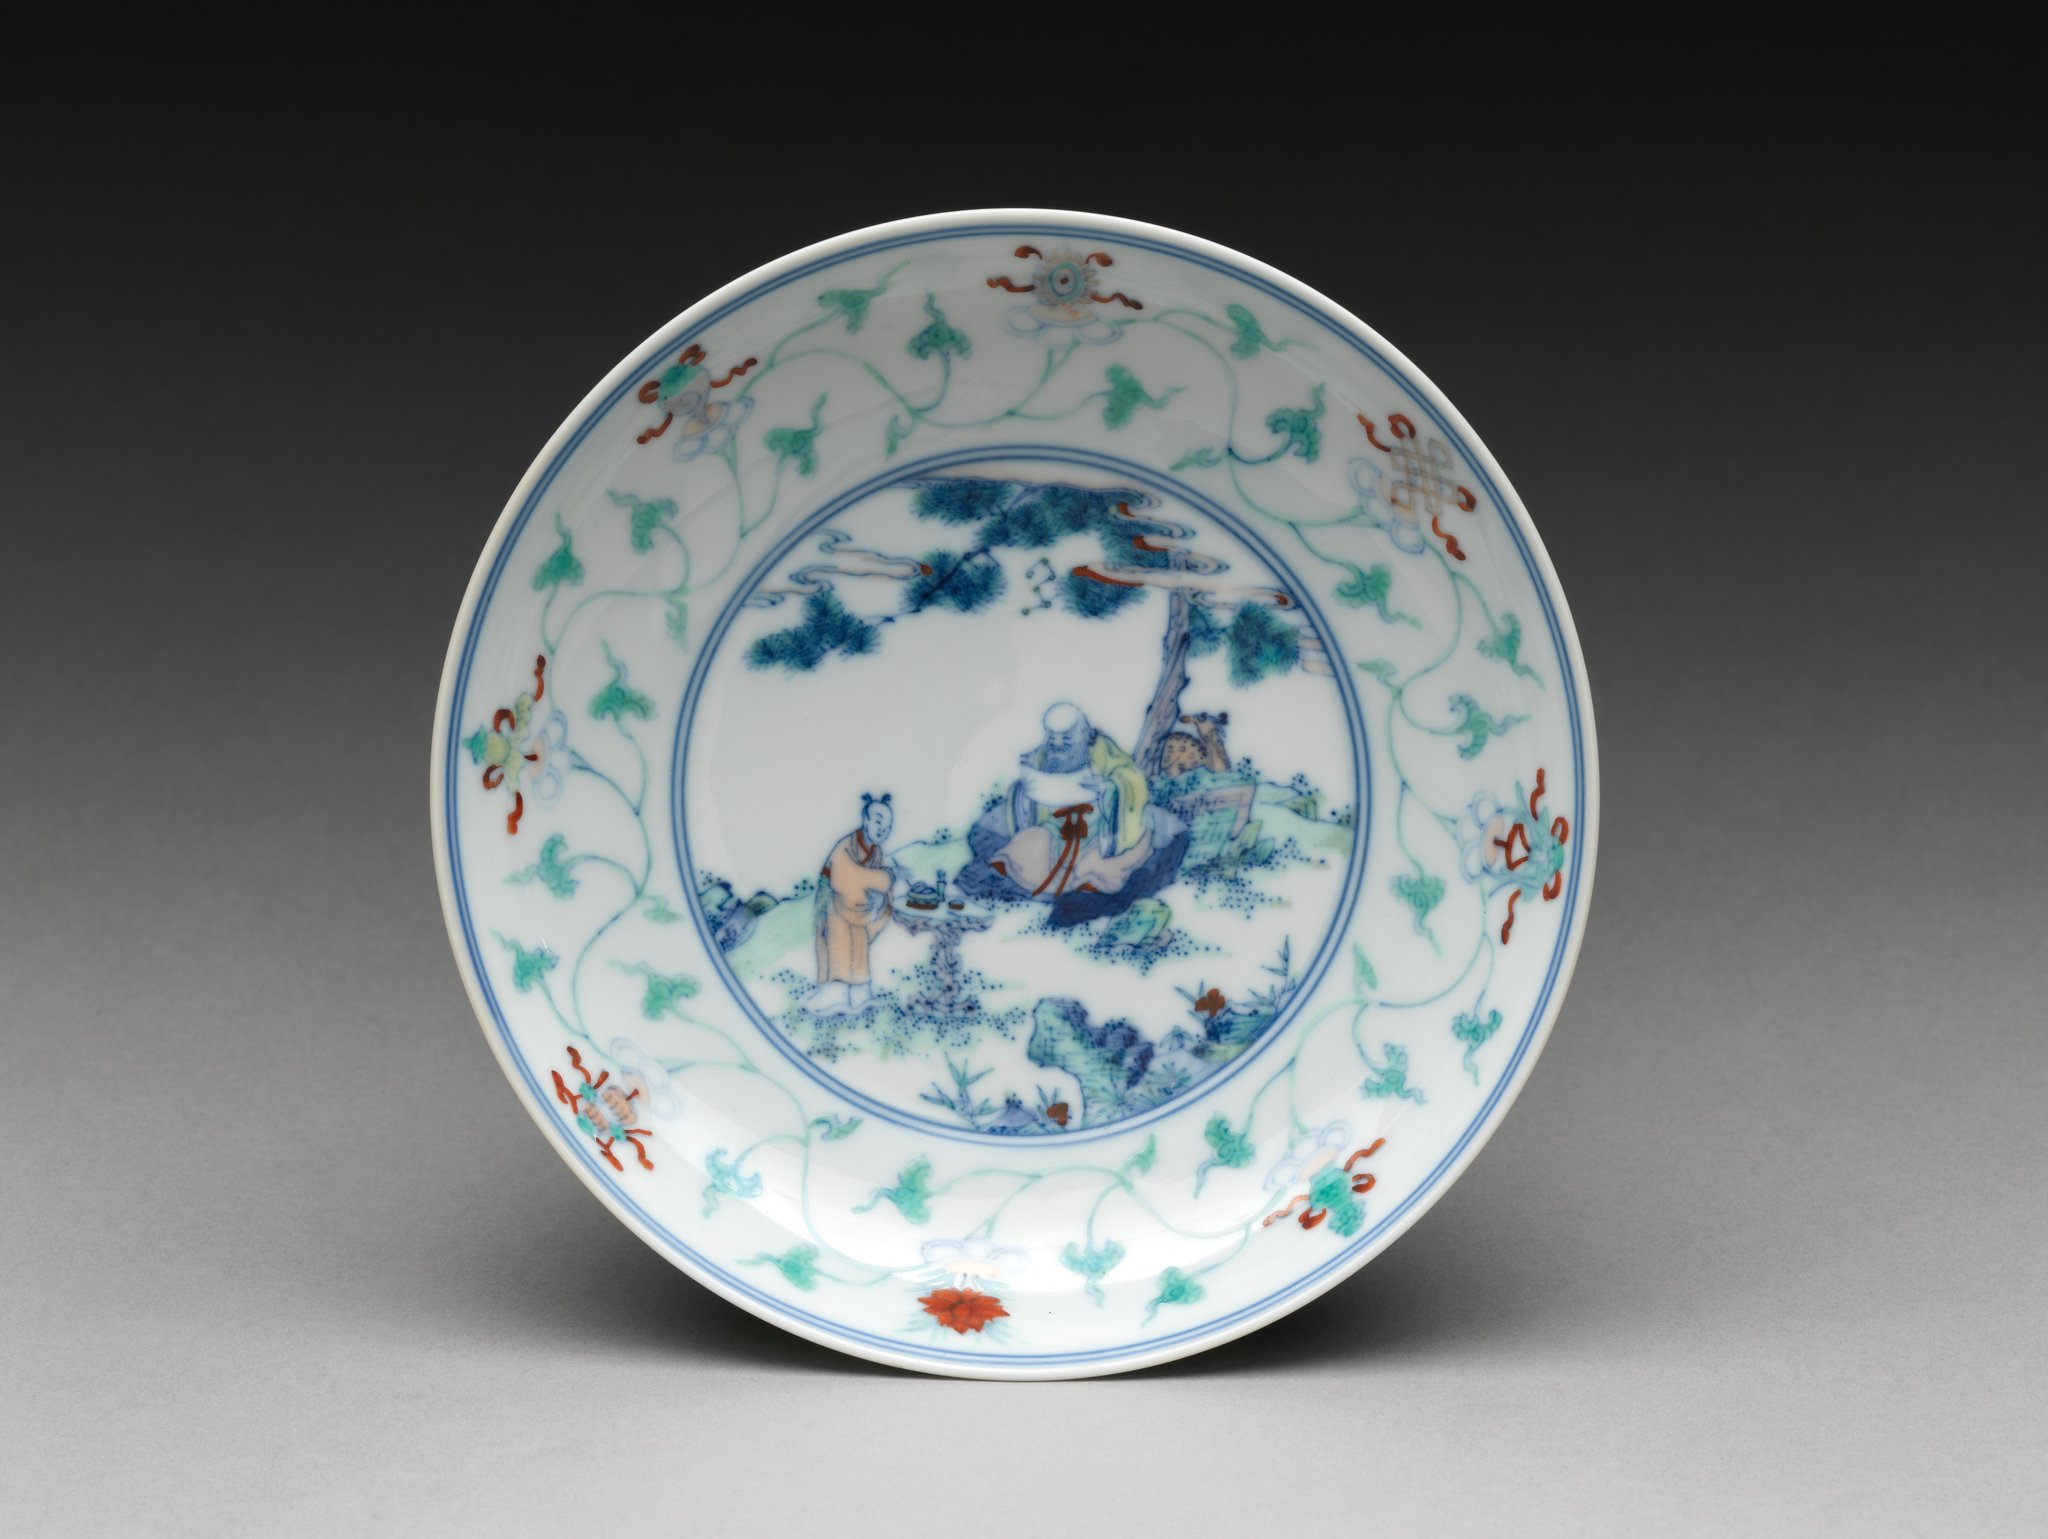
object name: dish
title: Dish with God of Longevity (Shoulao) and an attendant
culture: chinese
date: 1701-1800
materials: cobalt, enamel, porcelain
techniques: overglaze, painting, polychrome, underglaze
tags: men